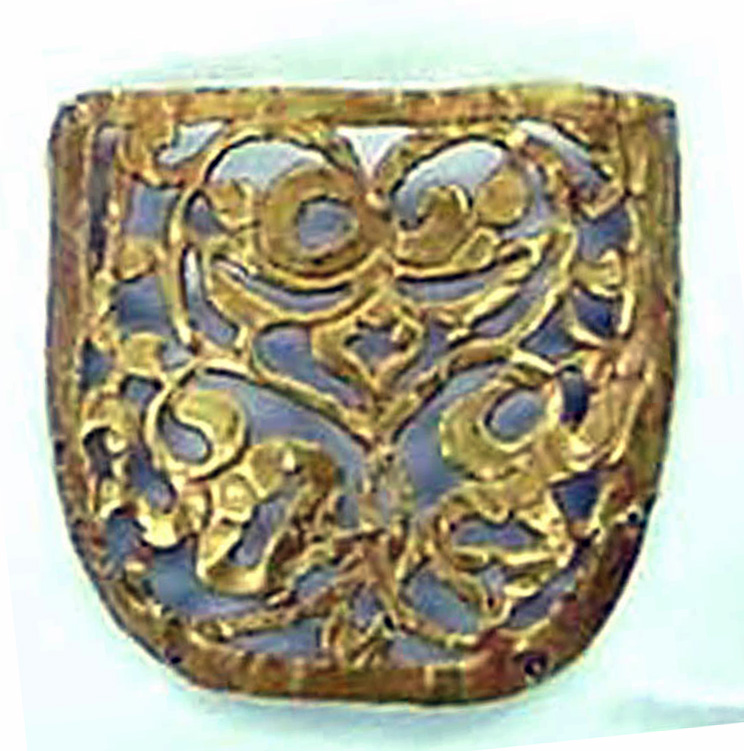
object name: fitting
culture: northwest chinese or eastern central asian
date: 634-900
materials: gold